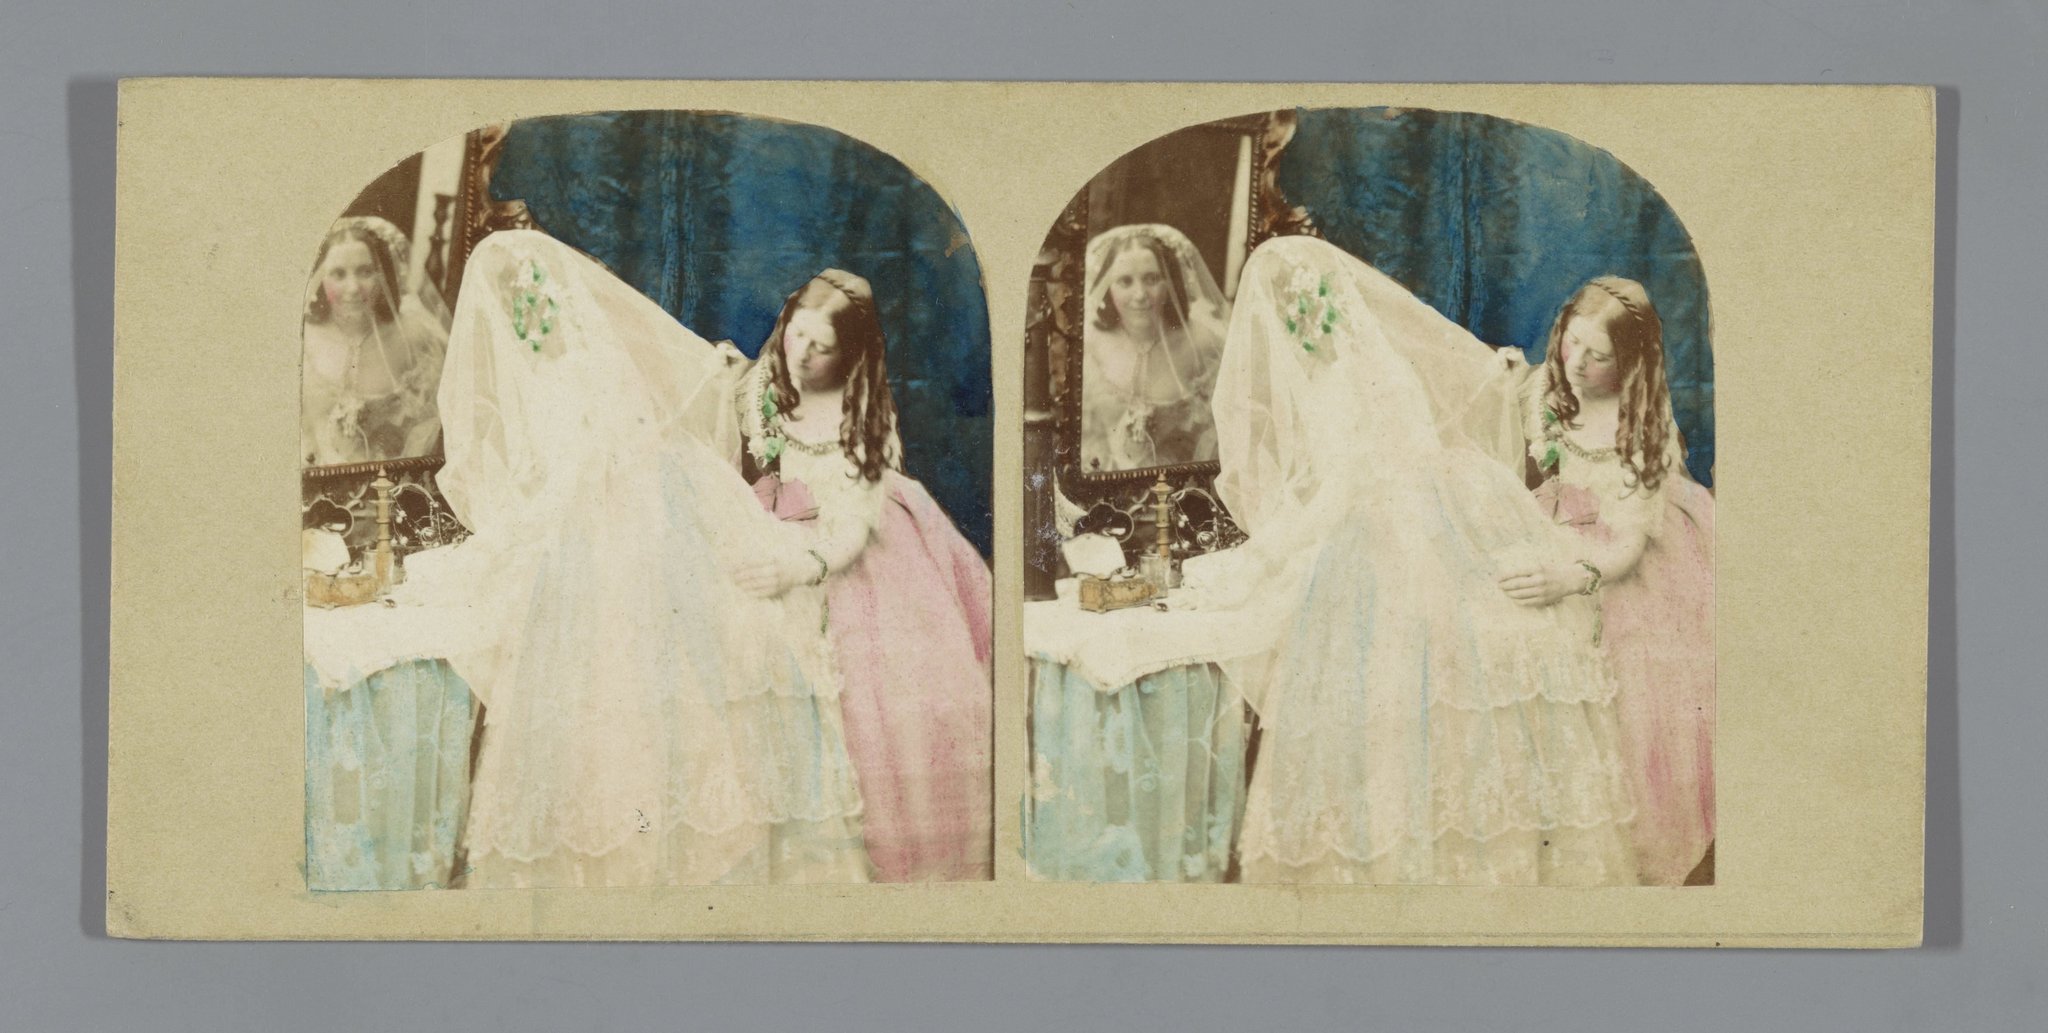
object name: stereograph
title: Bruid en bruidsmeisje voor een spiegel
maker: Anonymous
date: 1852-1858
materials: cardboard, paper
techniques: albumen print, hand coloring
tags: dressing the bride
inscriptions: inscription: ‘f 1-’, title: ‘de Bruid’